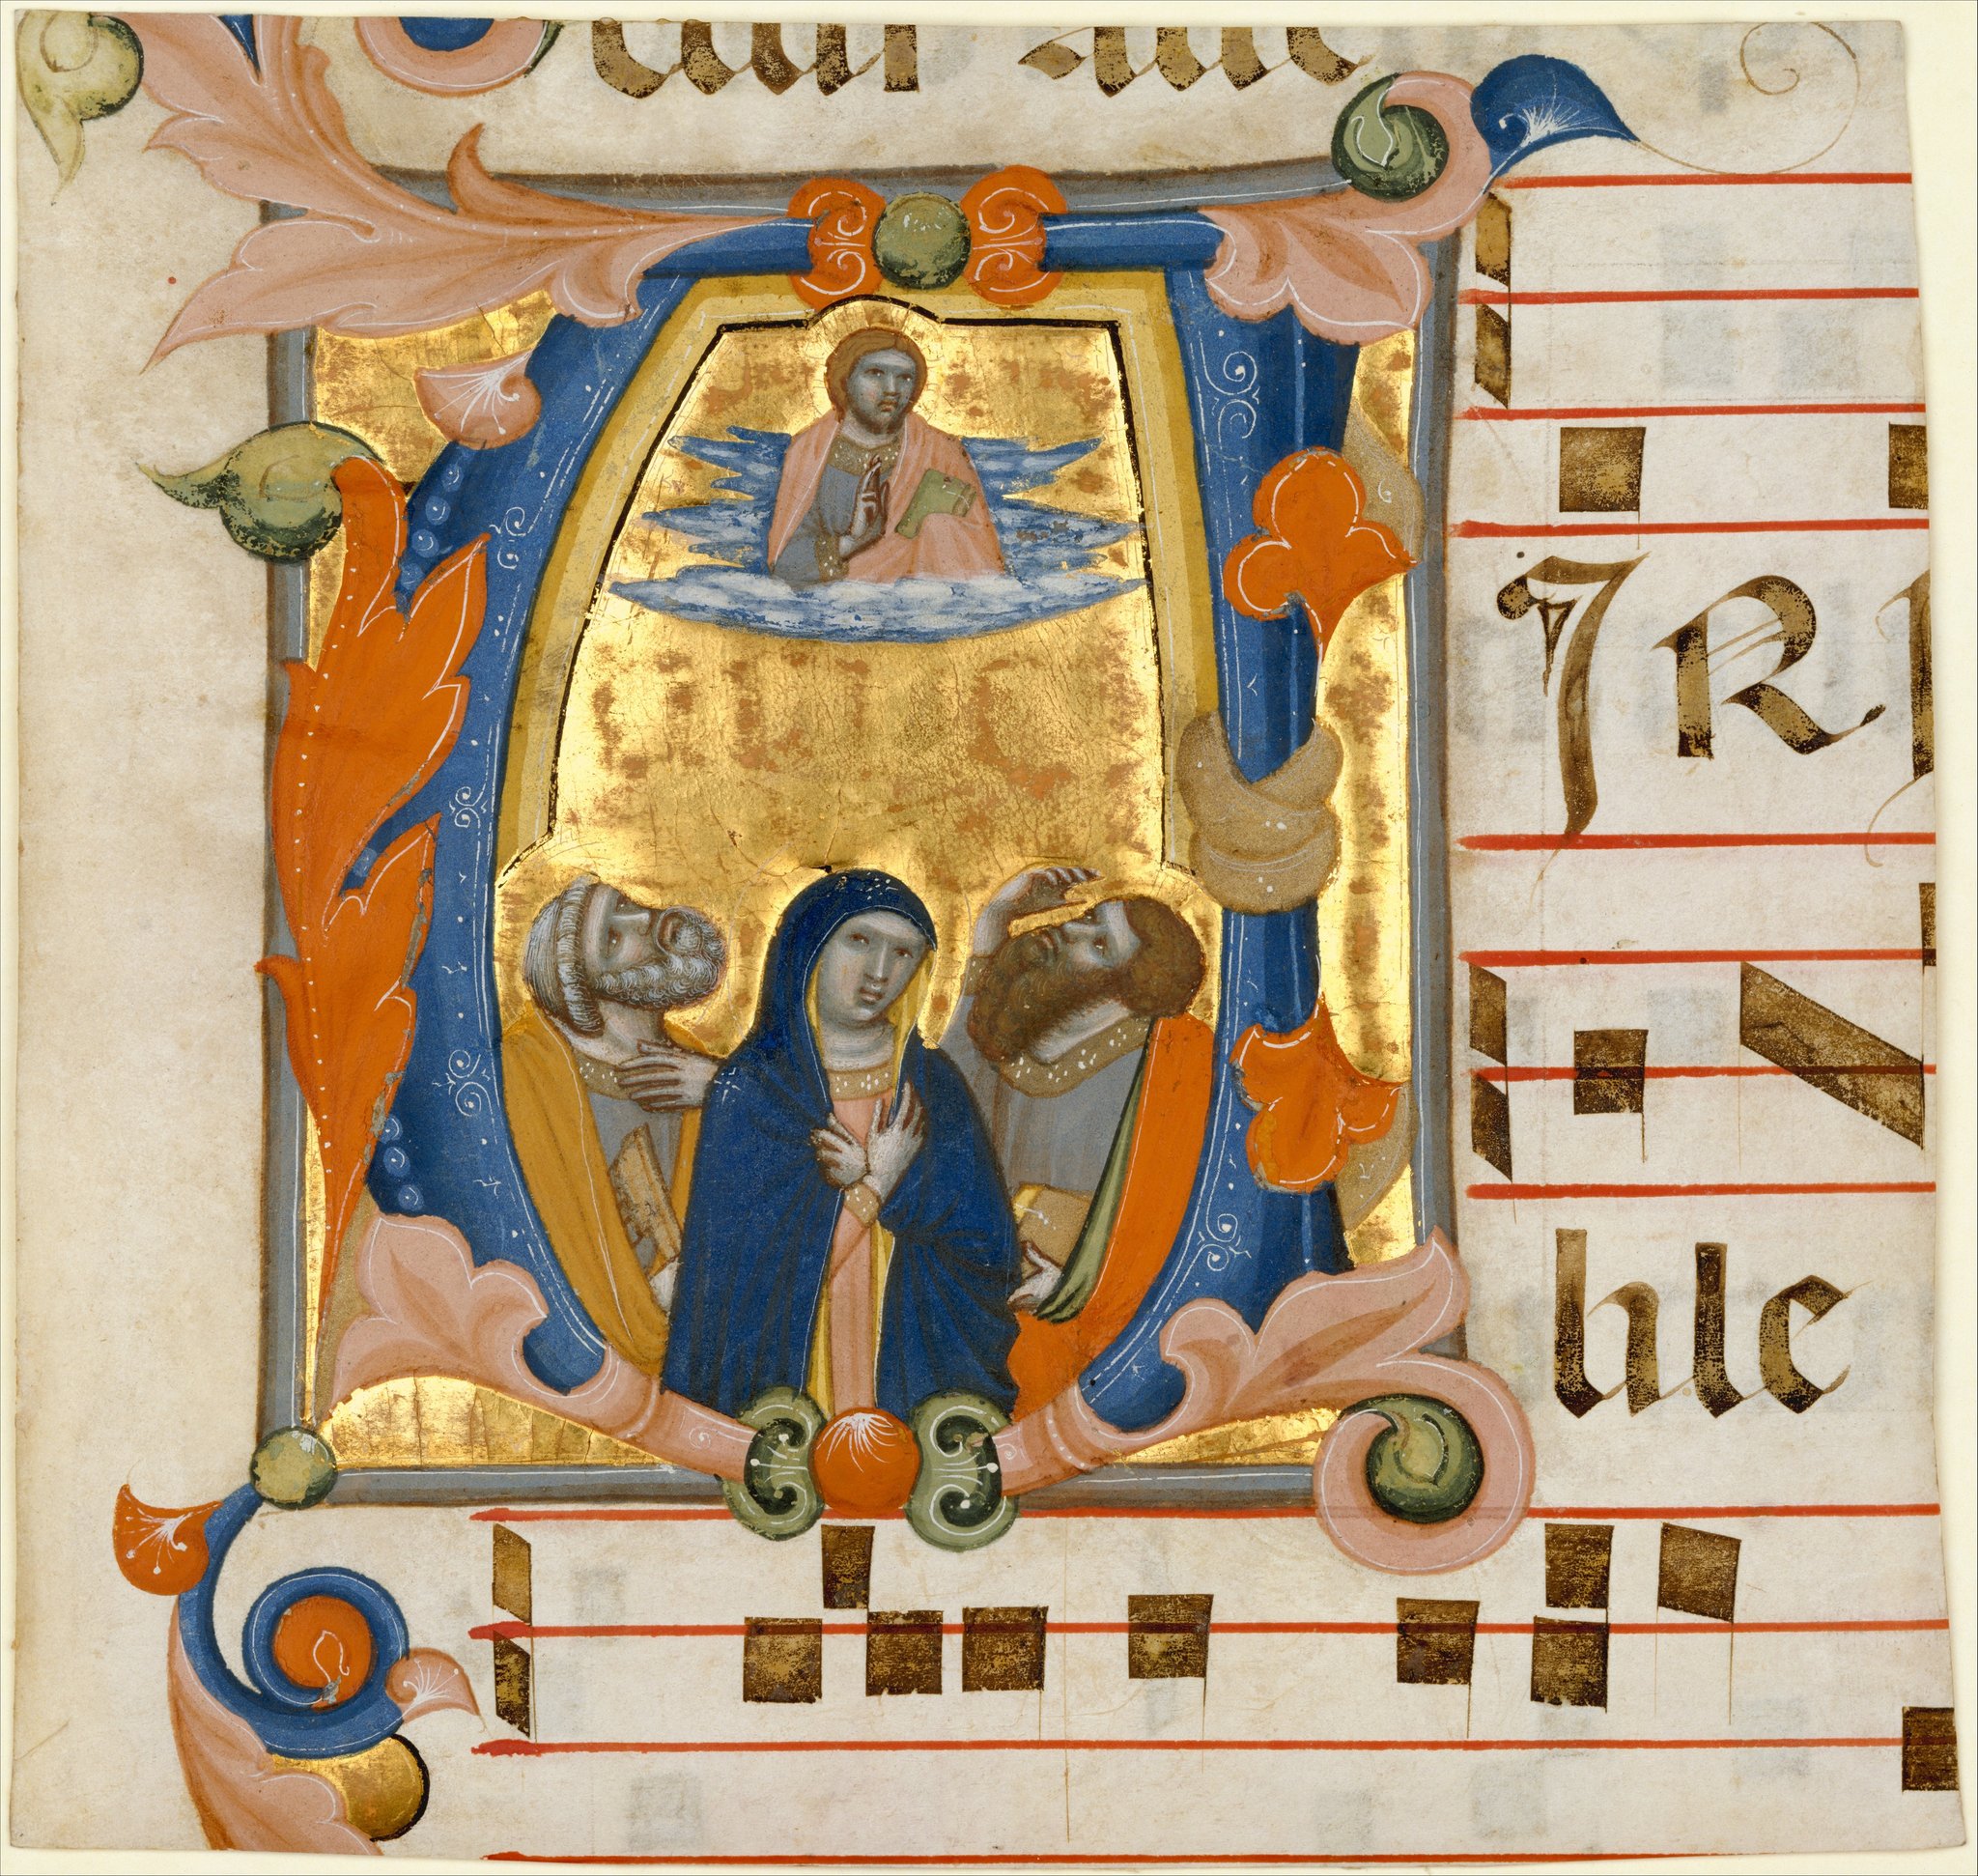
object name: cutting from an antiphonary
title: Ascension in an Initial V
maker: niccolò di ser sozzo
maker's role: artist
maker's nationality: italian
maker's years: 1329-1363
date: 1342-1350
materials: gold, parchment, paint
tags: christ,saint peter,virgin mary